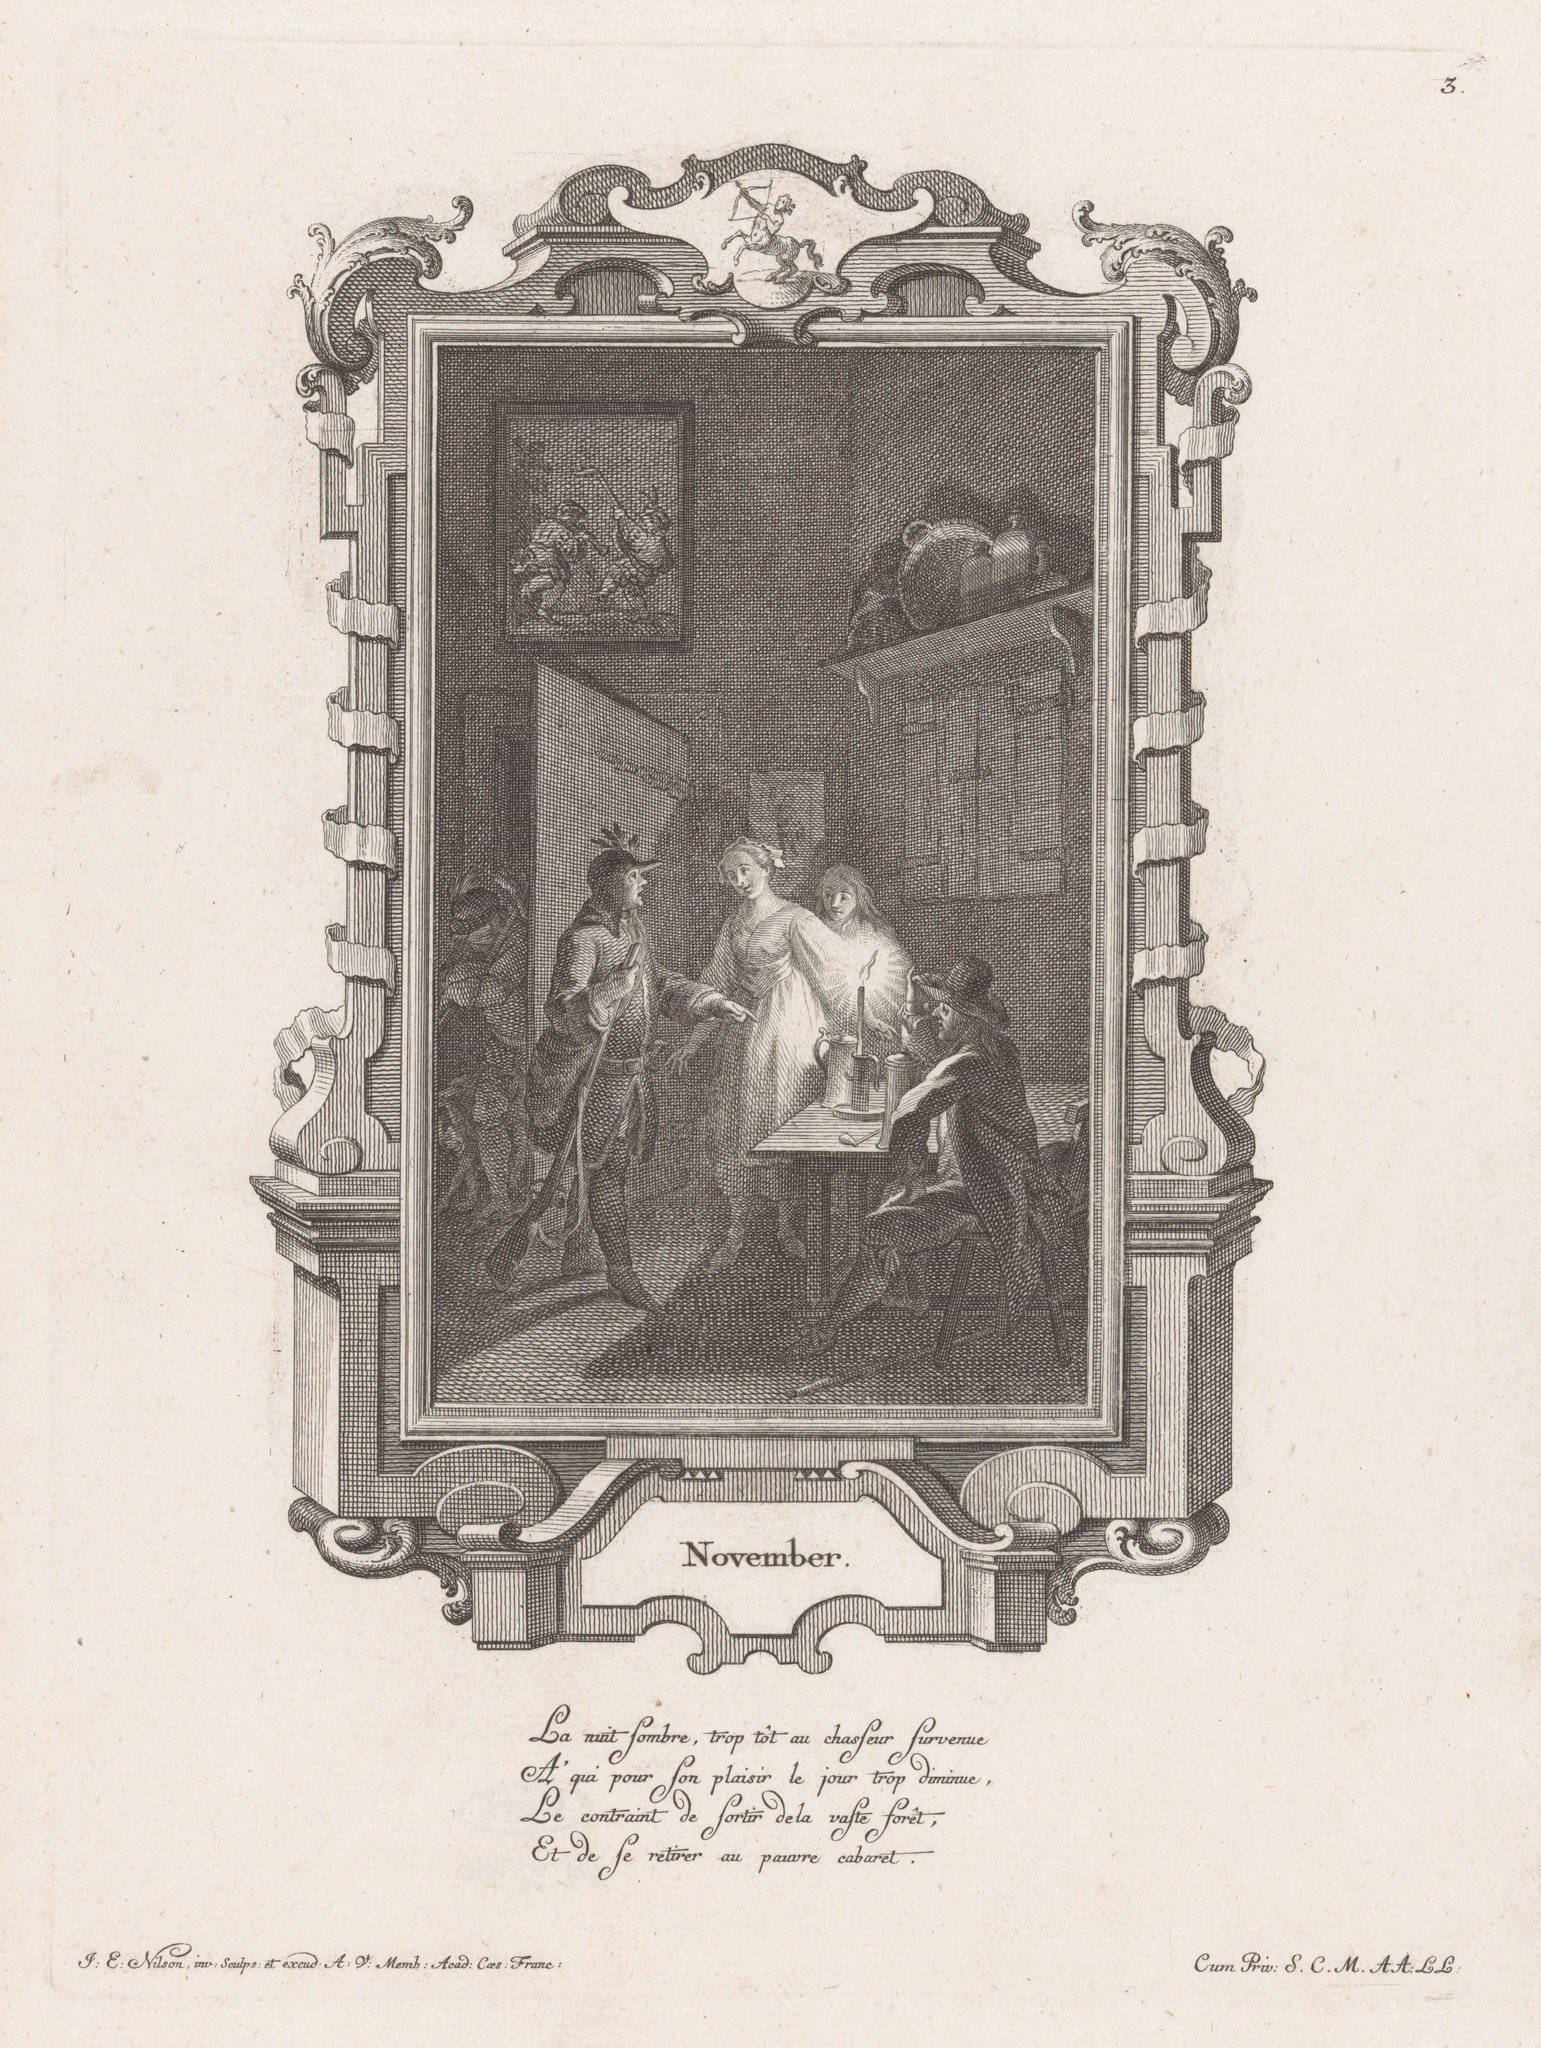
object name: print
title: November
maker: johann esaias nilson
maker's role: draughtsman, print maker, publisher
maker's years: 1721-1788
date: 1766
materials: paper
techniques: engraving, etching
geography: augsburg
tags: november and its 'labours', inn, coffee-house, public house, etc., return from the hunt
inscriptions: collector's mark: Lugt 2228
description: In een rocaille omlijsting een voorstelling van een jager. Een jager en zijn gevolg met de jachtbuit lopen een café binnen. Twee vrouwen en een man staan en zitten rondom een tafel met bierpullen. De ruimte wordt door een kaars verlicht. In de ondermarge een vierregelige Franse tekst.